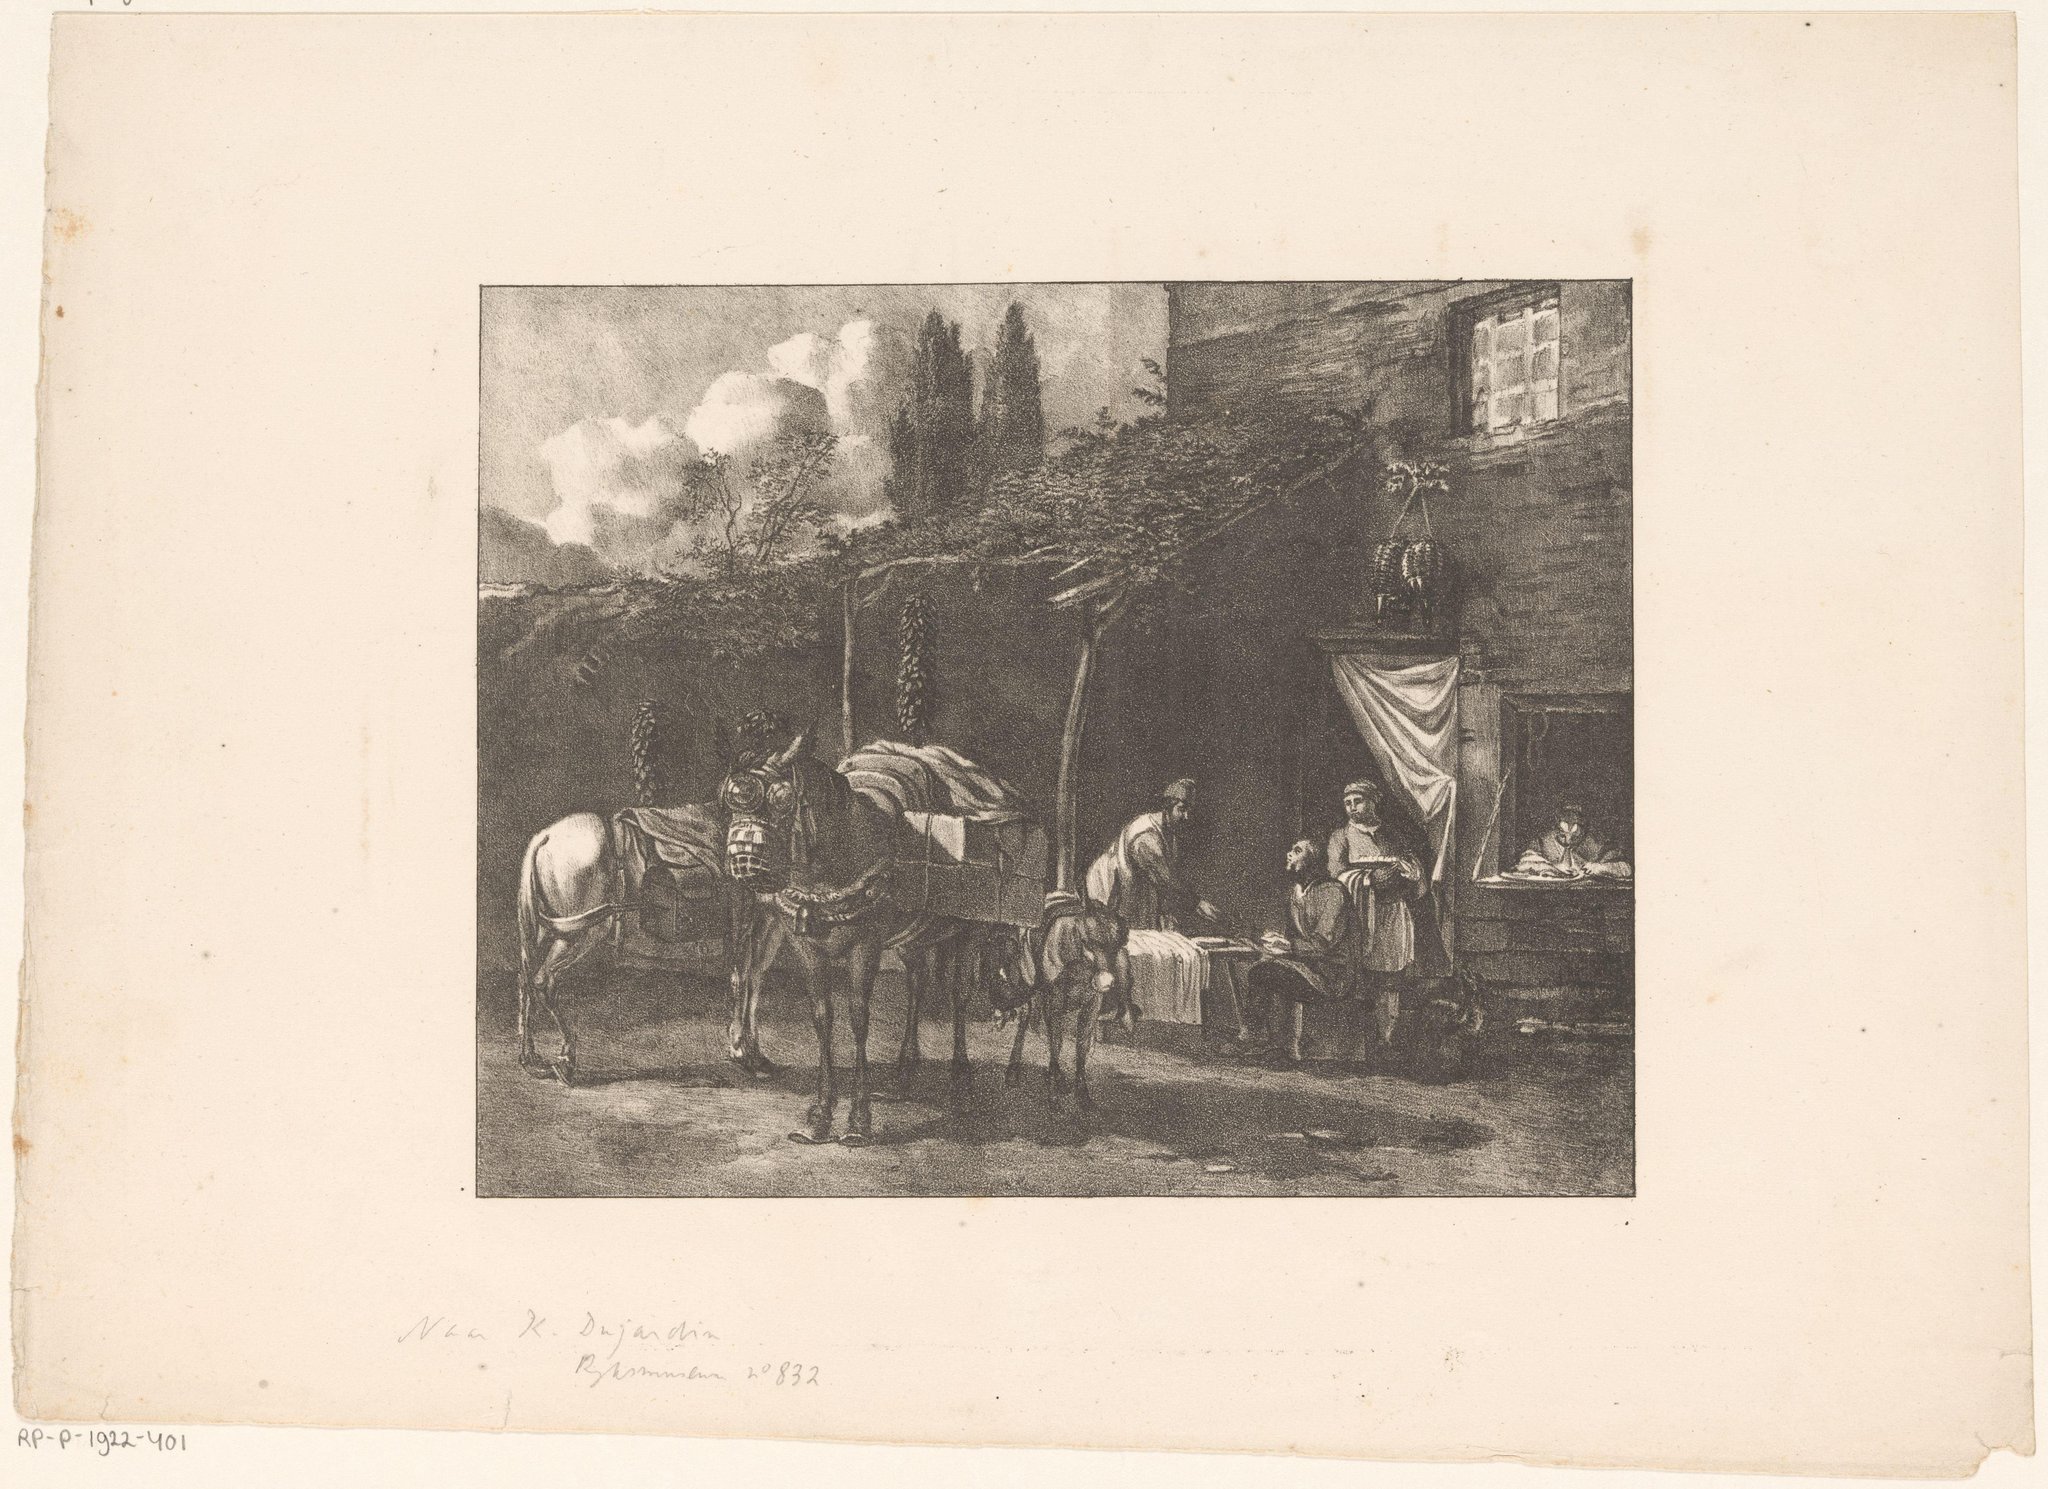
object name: print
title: Drie ezels voor herberg, naar Duzardin. R.M. 832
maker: Anonymous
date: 1809-1899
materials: paper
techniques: lithograph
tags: hotel, hostelry, inn, mule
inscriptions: collector's mark: Lugt 2233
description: Muilezeldrijvers bij een Italiaanse herberg. Een man zit aan een tafel op de binnenplaats van een herberg en wordt door twee mannen bediend. Links staan twee muilezels en een paard.